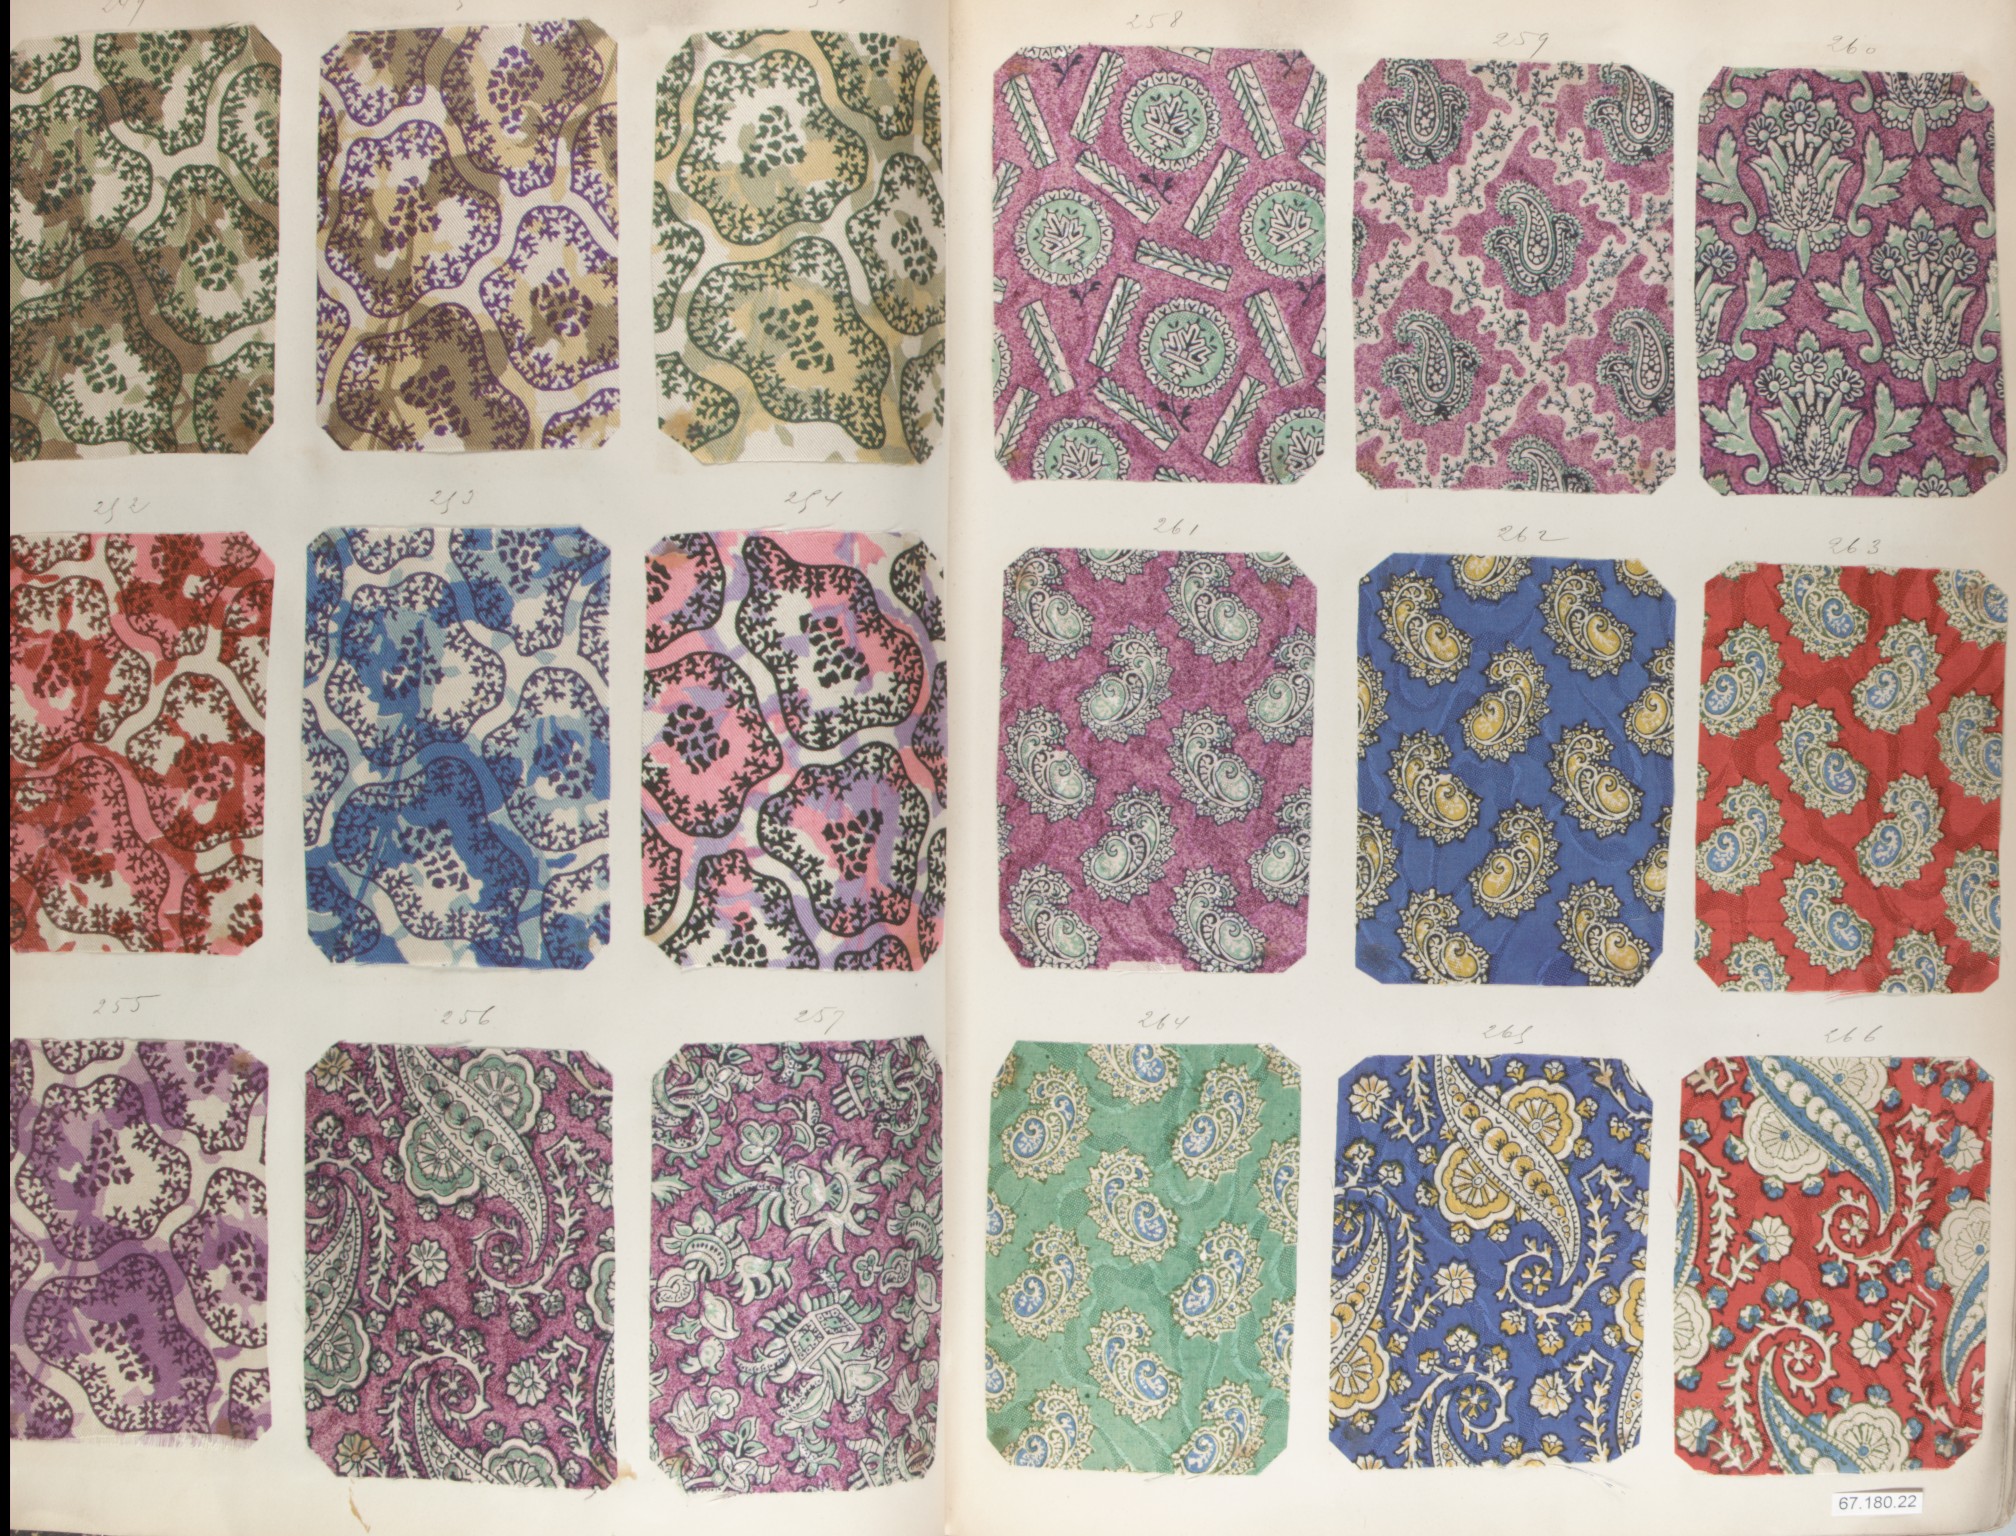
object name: sample book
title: Textile Sample Book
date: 1898